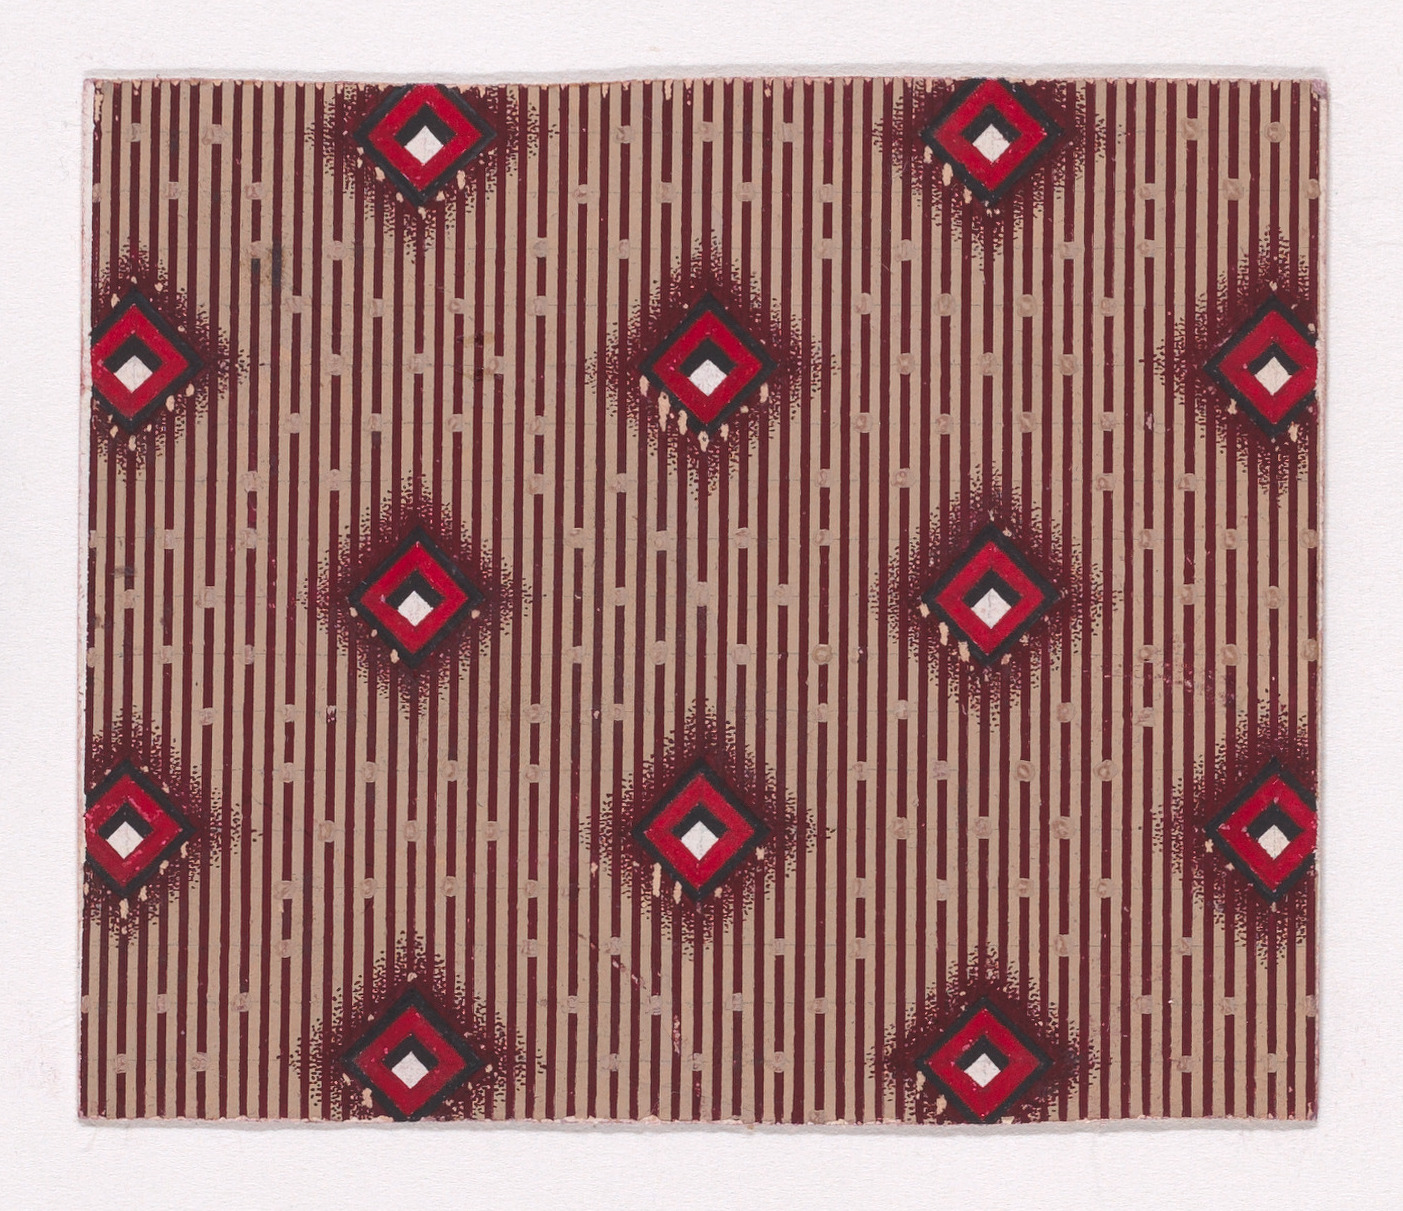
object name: drawing ornament architecture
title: Textile Design with Alternating Lozenges over a Striped Background of Intermittent Lines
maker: anonymous, alsatian, 19th century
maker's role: artist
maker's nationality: alsatian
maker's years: 1800-1900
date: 1840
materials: gouache